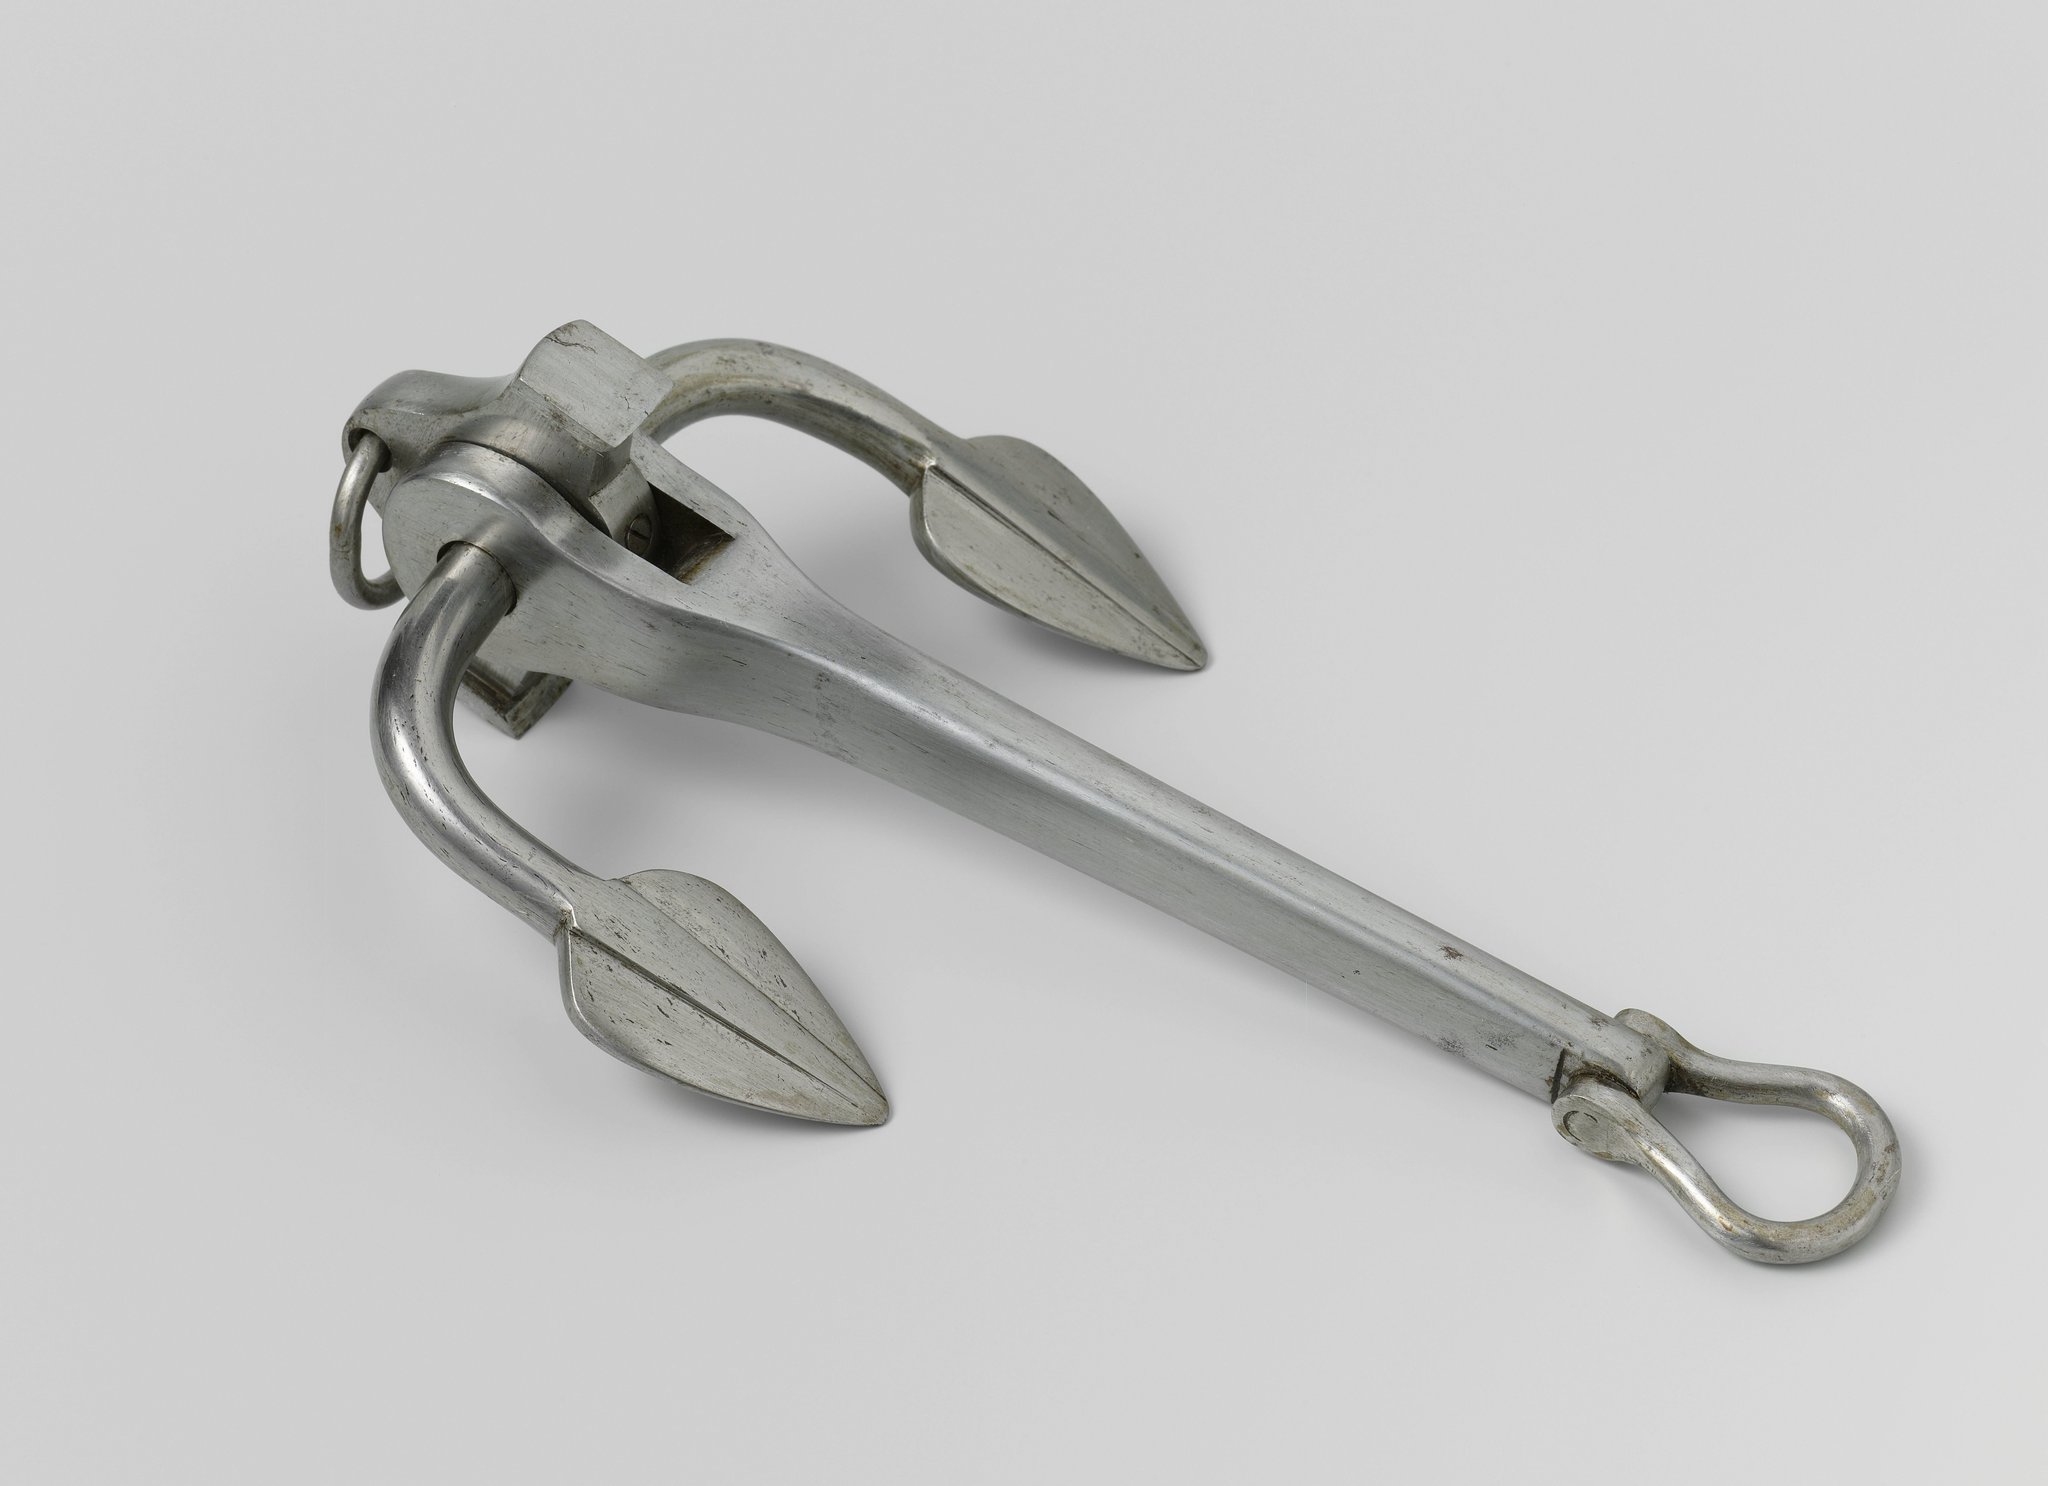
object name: instruction model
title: Model of an Anchor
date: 1864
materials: iron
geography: marseille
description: Het securitas-anker was een verbeterde versie van het Hawkins patent anker en werd gepatenteerd door L.J. Vonk in Den Haag in 1853; de vorm van de ankerstok is gewijzigd. Het voldeed goed als daganker bij proefnemingen met de Wassenaer, maar later op de Zoutman in Japan bleek het niet te houden in moddergrond. Het was bovendien moeilijk te katten en te kippen.